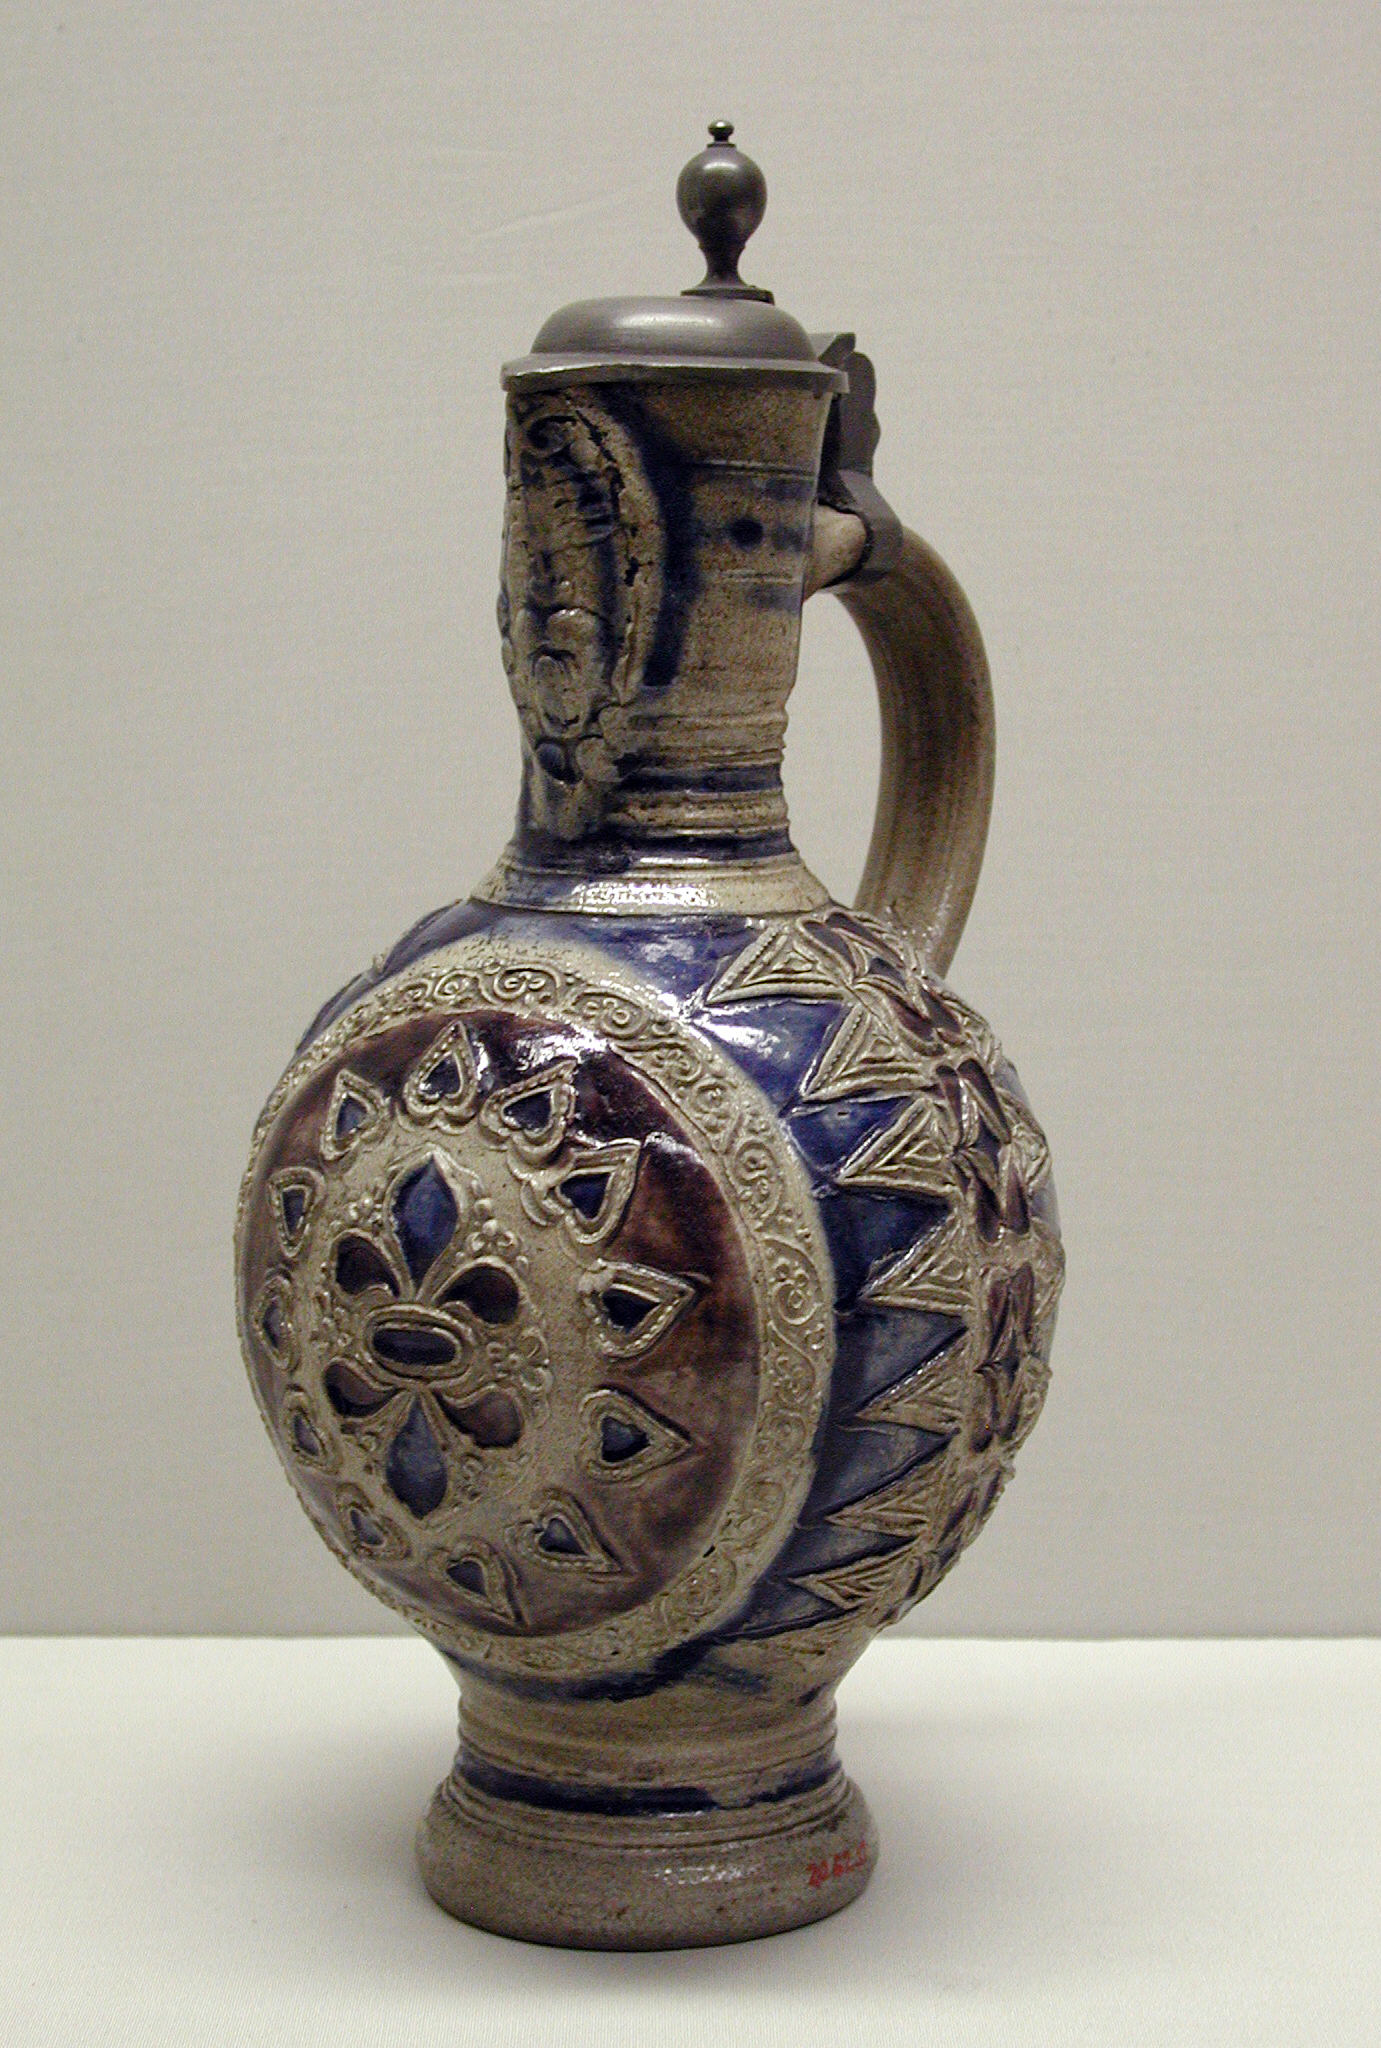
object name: jug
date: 1701-1800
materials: pewter, stoneware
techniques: salt glaze